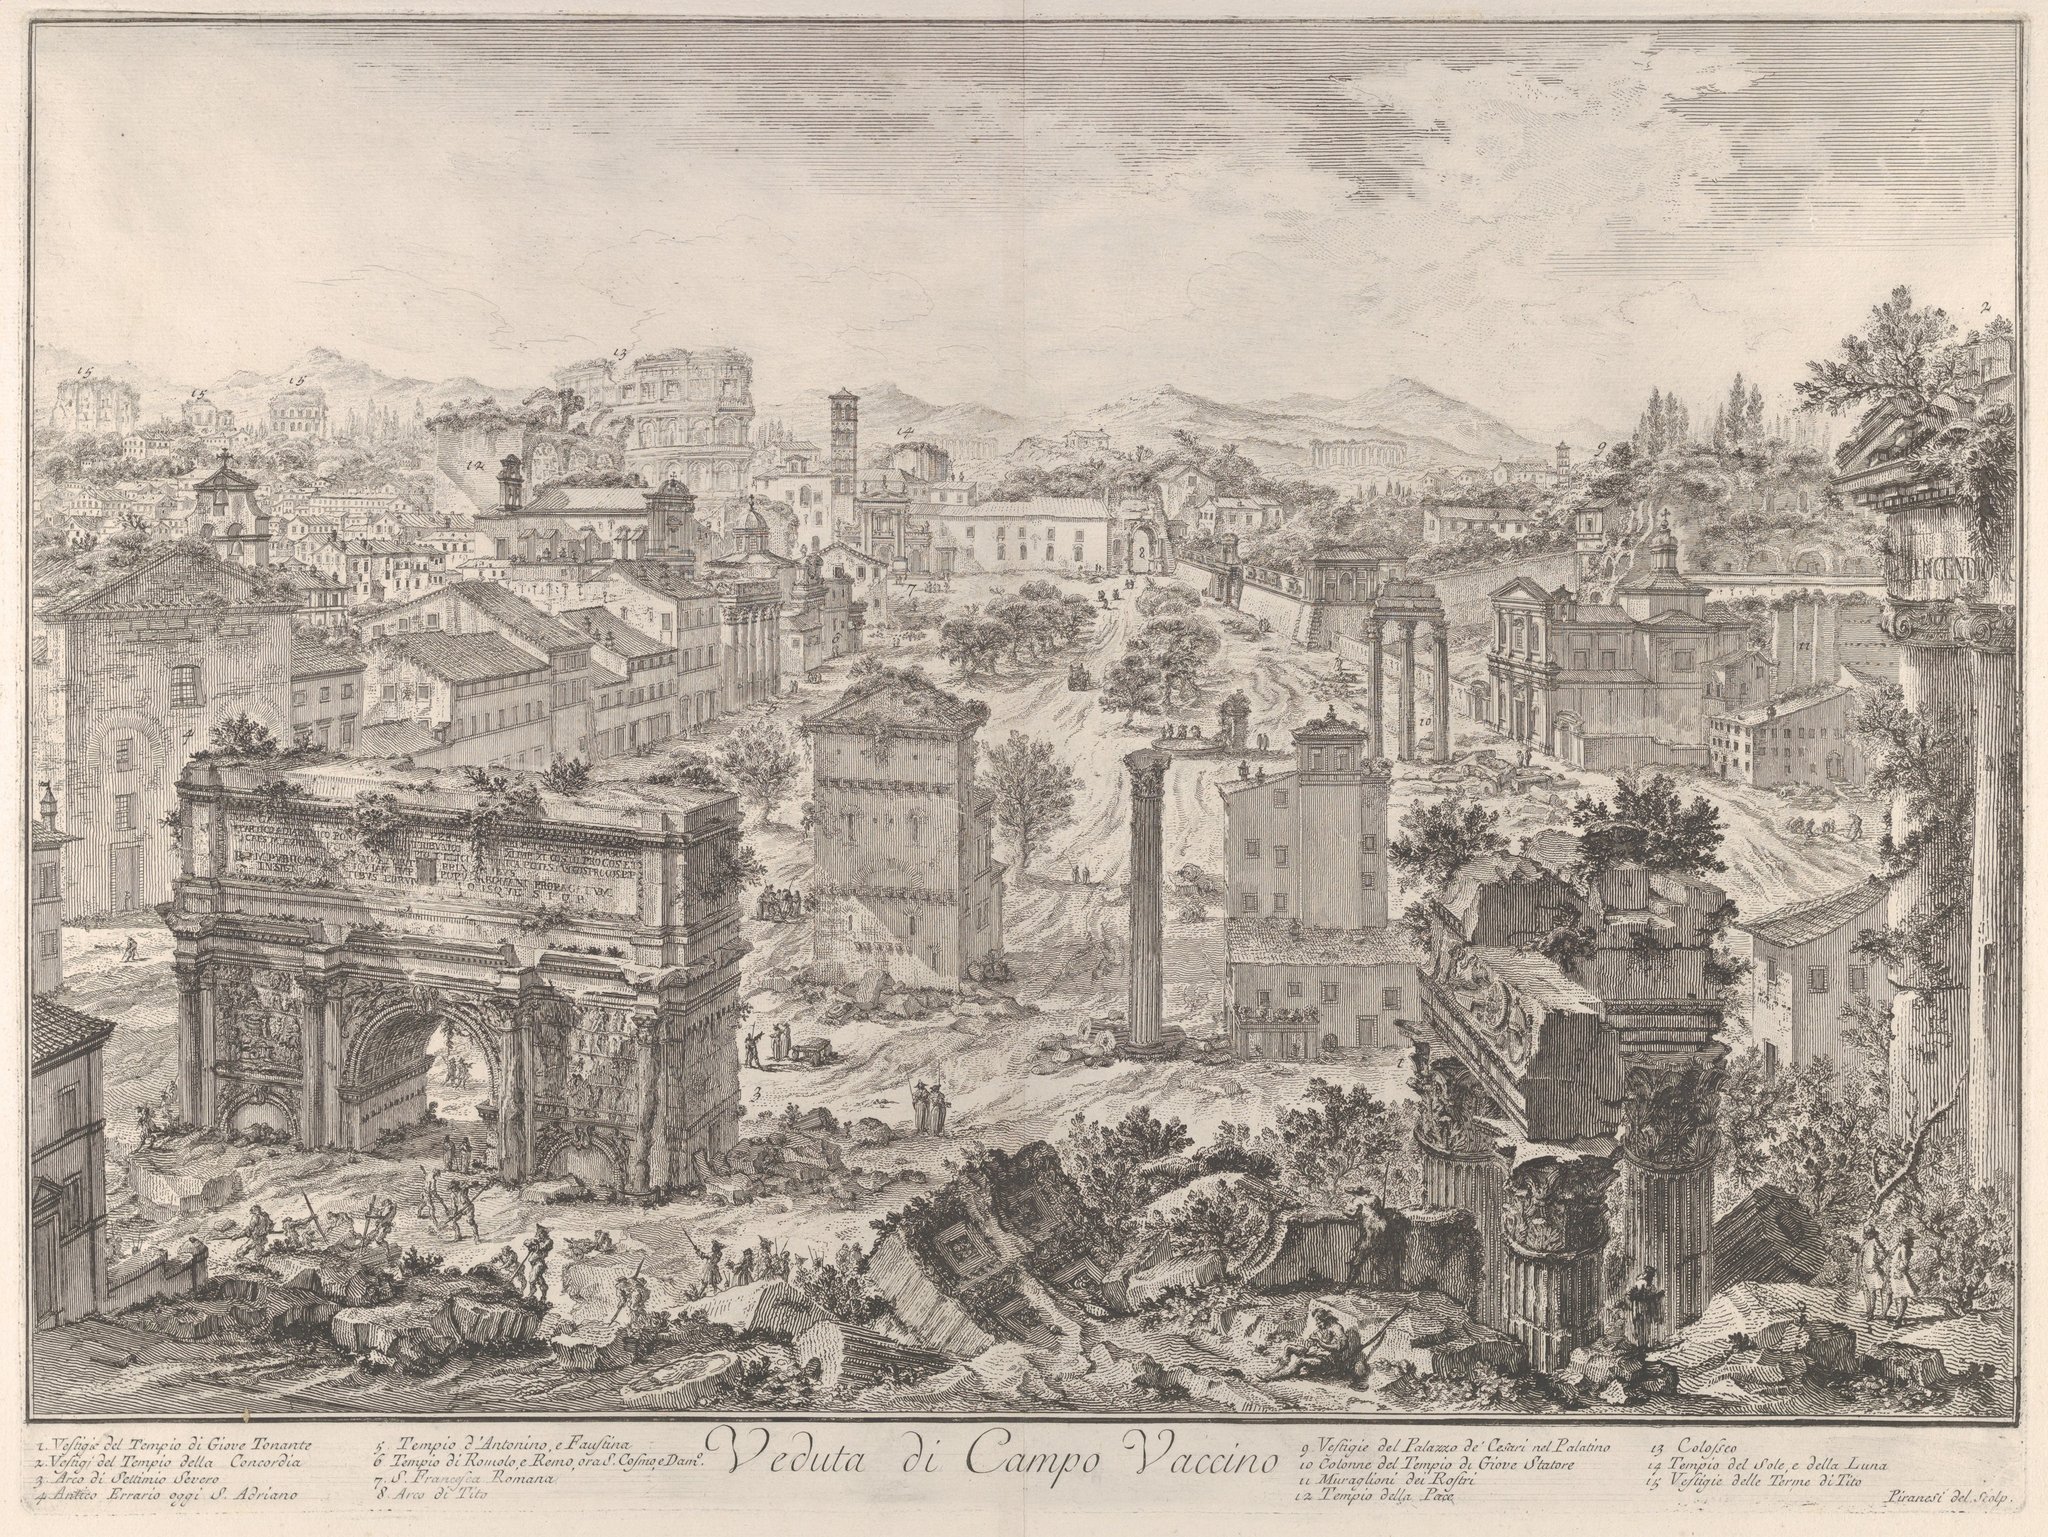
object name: print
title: The Forum Romanum, or Campo Vaccino, from the capitol, with the Arch of Septimus Severus in the foreground left, Temple of Vespian right, and the Colosseum in the distance (Veduta di Campo Vaccino), from "Vedute di Roma"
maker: giovanni battista piranesi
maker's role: artist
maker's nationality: italian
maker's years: 1720-1778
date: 1775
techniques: etching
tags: buildings,cities,ruins